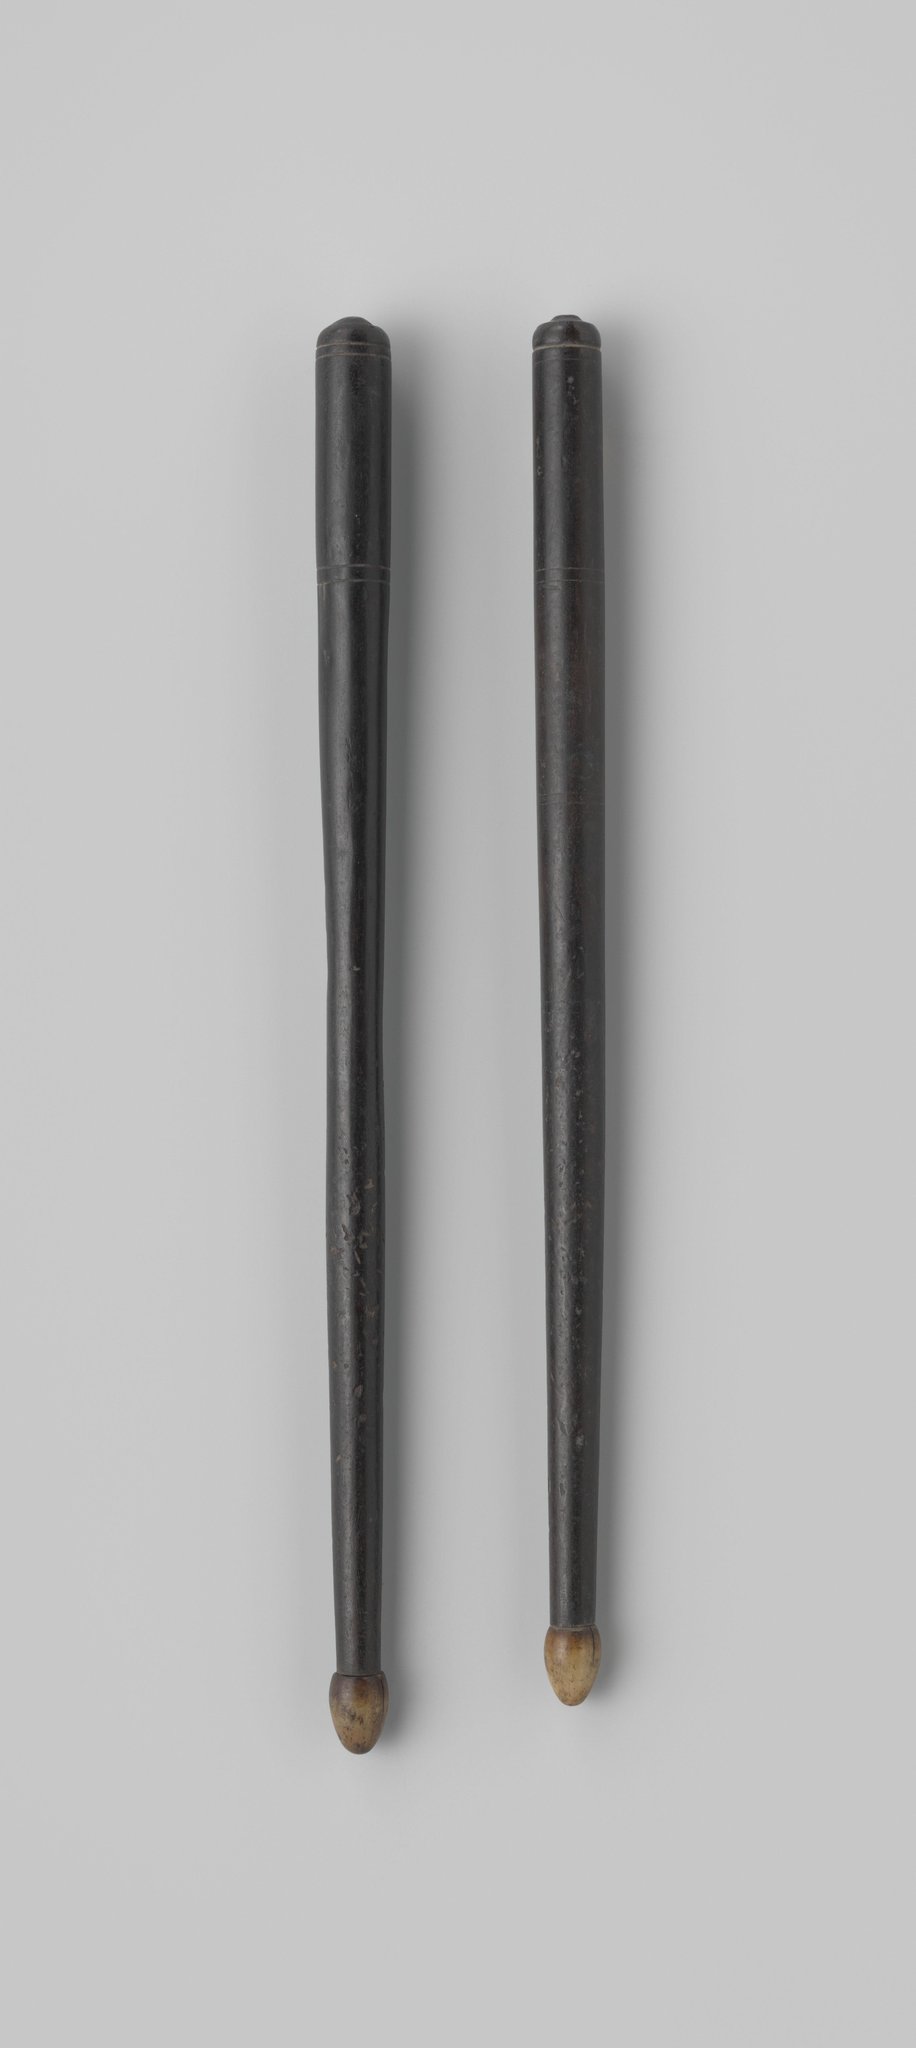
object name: element of musical instrument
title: Drumsticks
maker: Anonymous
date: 1850-1900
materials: bone, wood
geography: netherlands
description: - Tromstok van hout met knop van been voor tamboer leger of schutterij, Nederland, ca. 1850-1900. - Tromstok vml. voor tamboer leger of schutterij, ca. 1850-1900, Nederland.